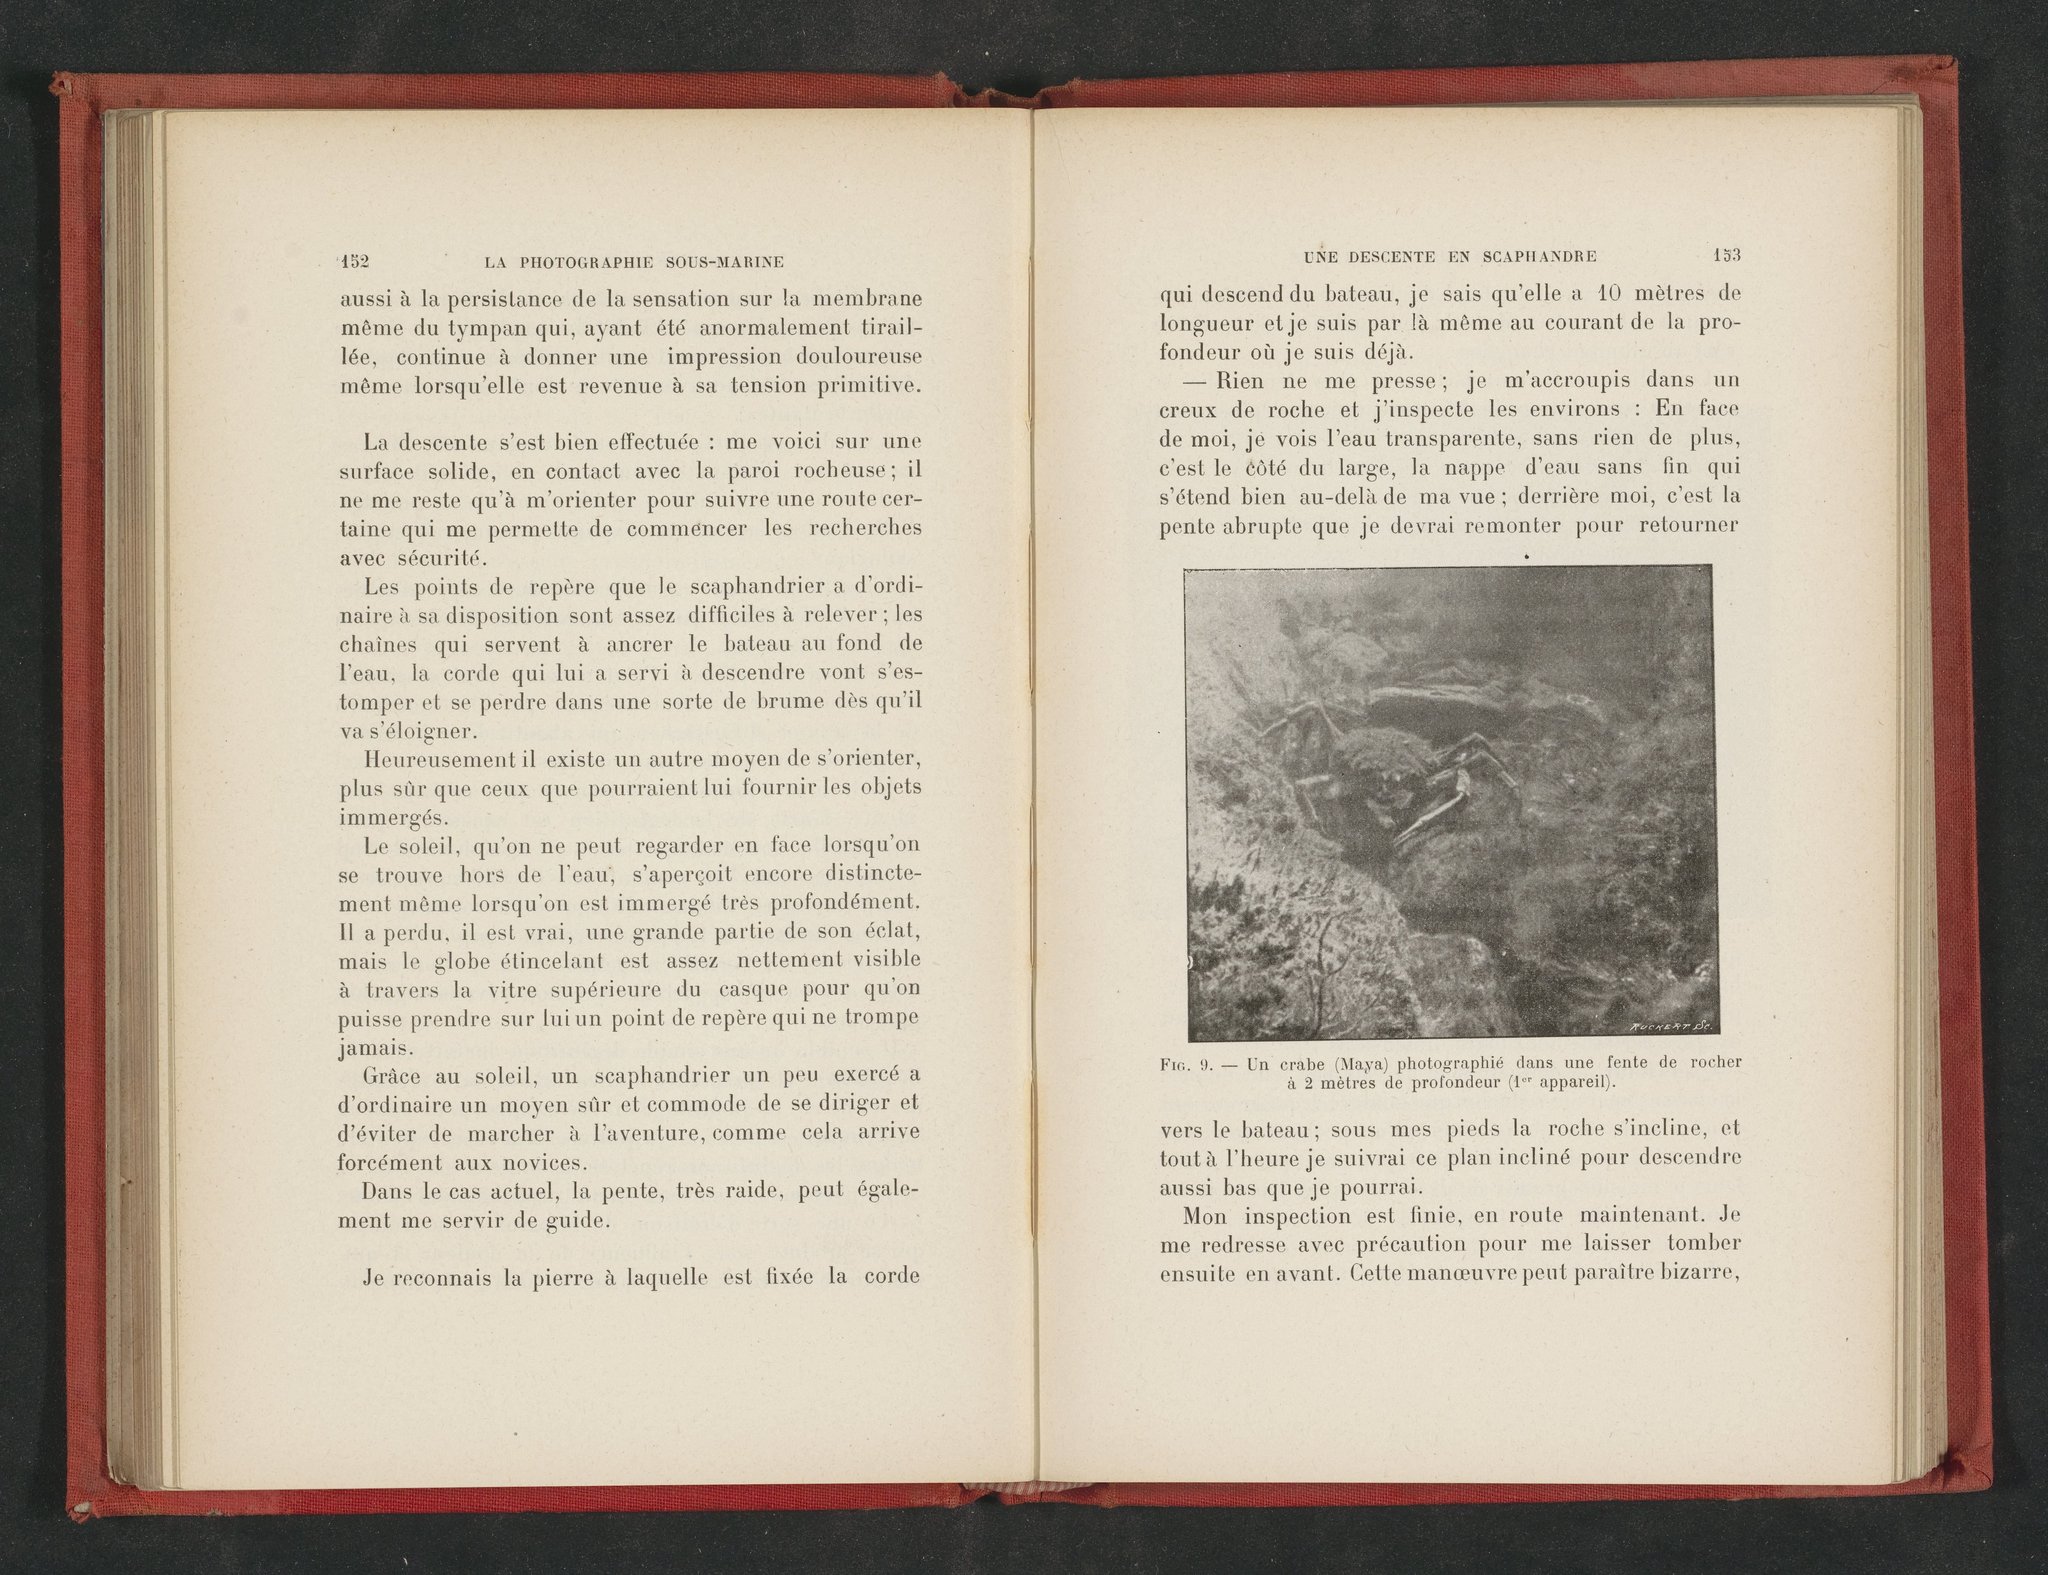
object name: photomechanical print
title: Un crabe (Maya) photographié dans une fente de rocher à 2 mètres de profondeur (1er appareil)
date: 1890-1900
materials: paper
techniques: autotype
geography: france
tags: crustaceans: crab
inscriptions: number: ‘Fig. 9.’